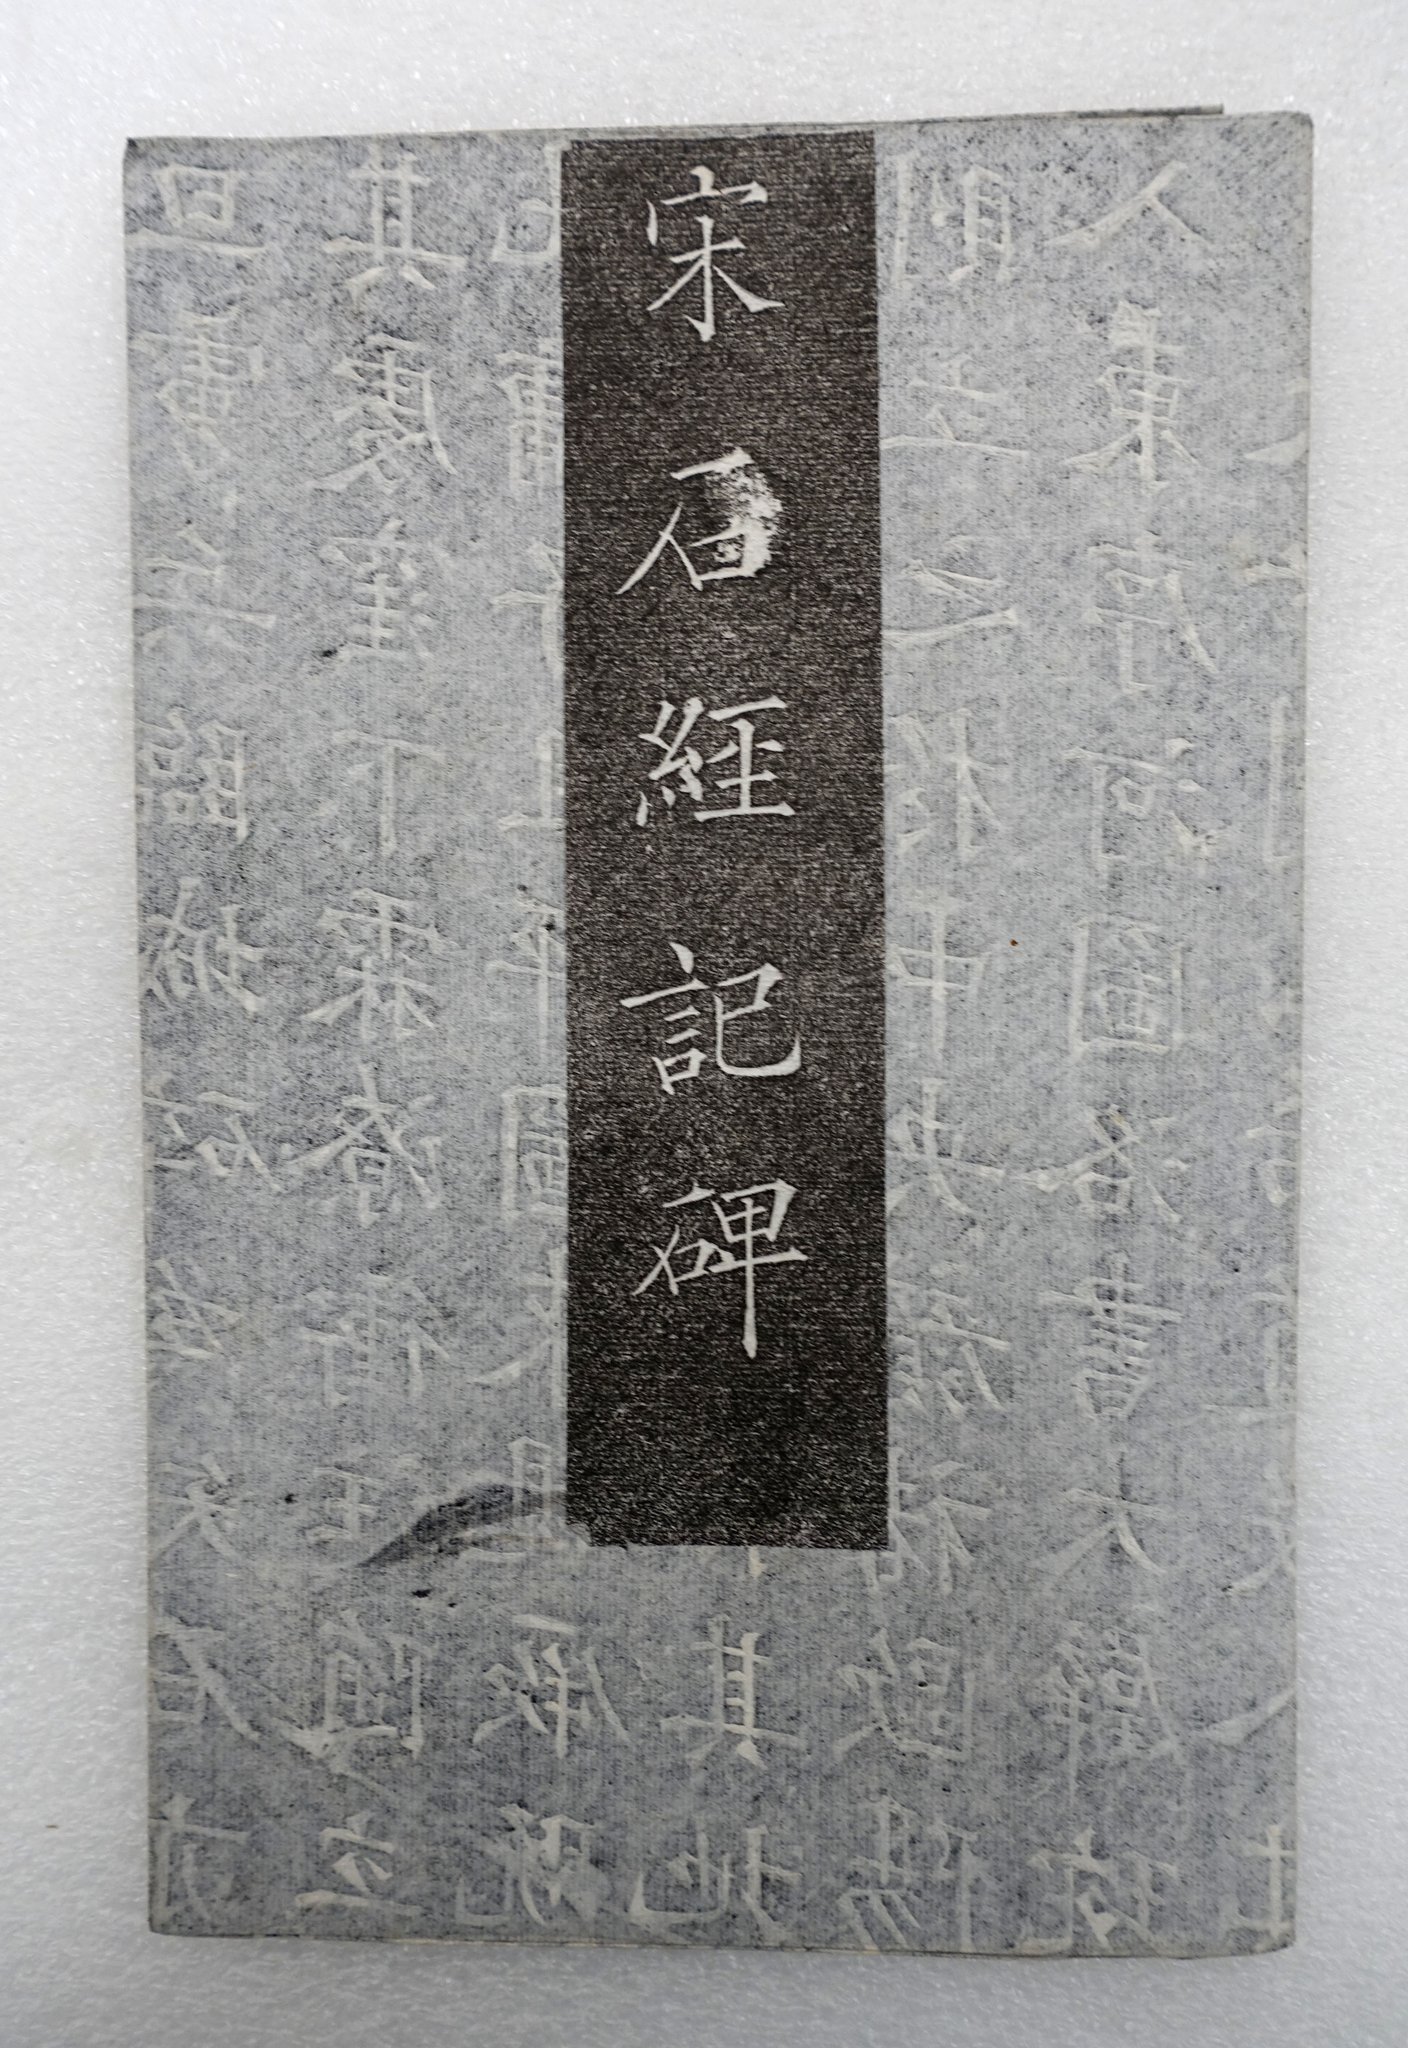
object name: rubbing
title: Recording the Recent Move of the "Stone Classics" to the Academy in the Capital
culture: chinese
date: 1901-2000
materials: ink, paper